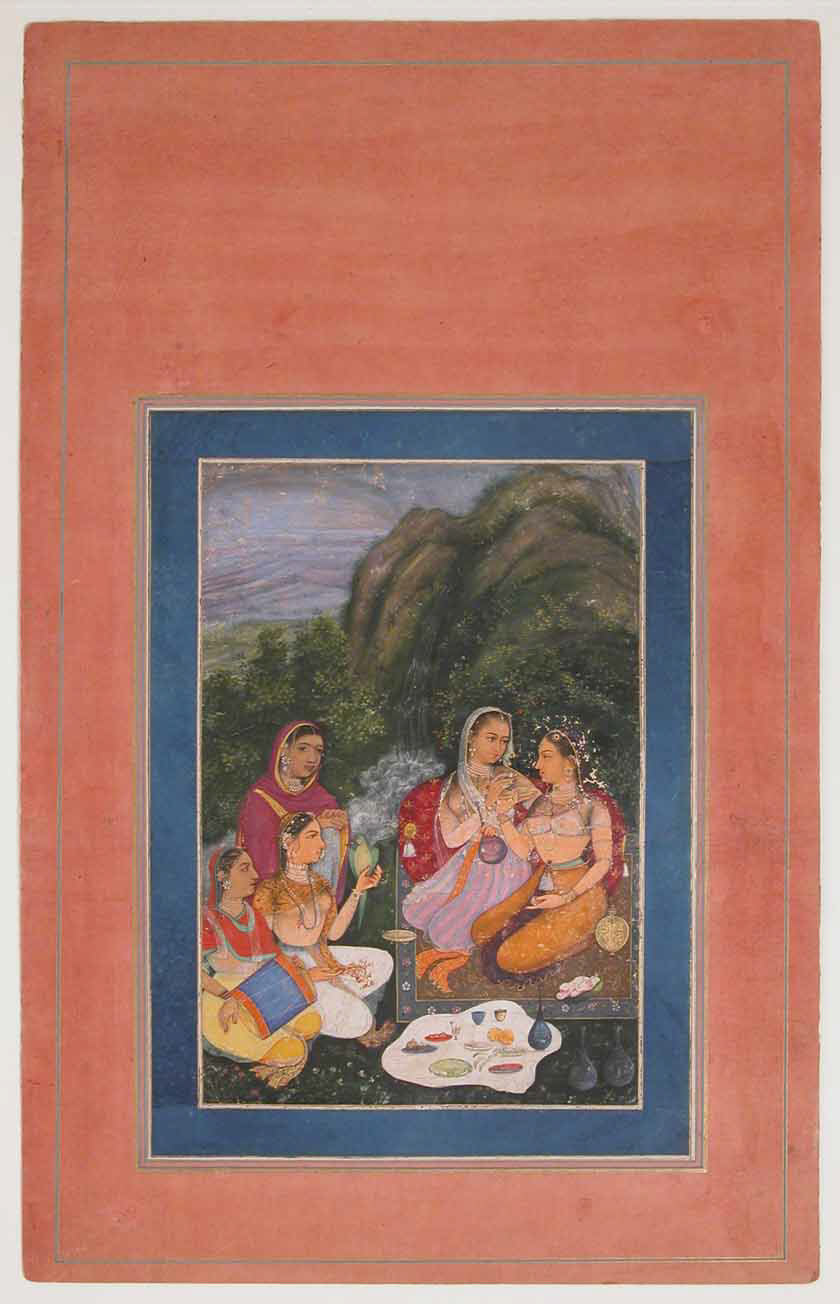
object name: illustrated album leaf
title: "Princess with Attendants Picnicking in the Open Air", Folio from the Davis Album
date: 1701-1800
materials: gold, ink, paper, watercolor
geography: india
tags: food,birds,princesses,women,drums,drinking,eating,picnics